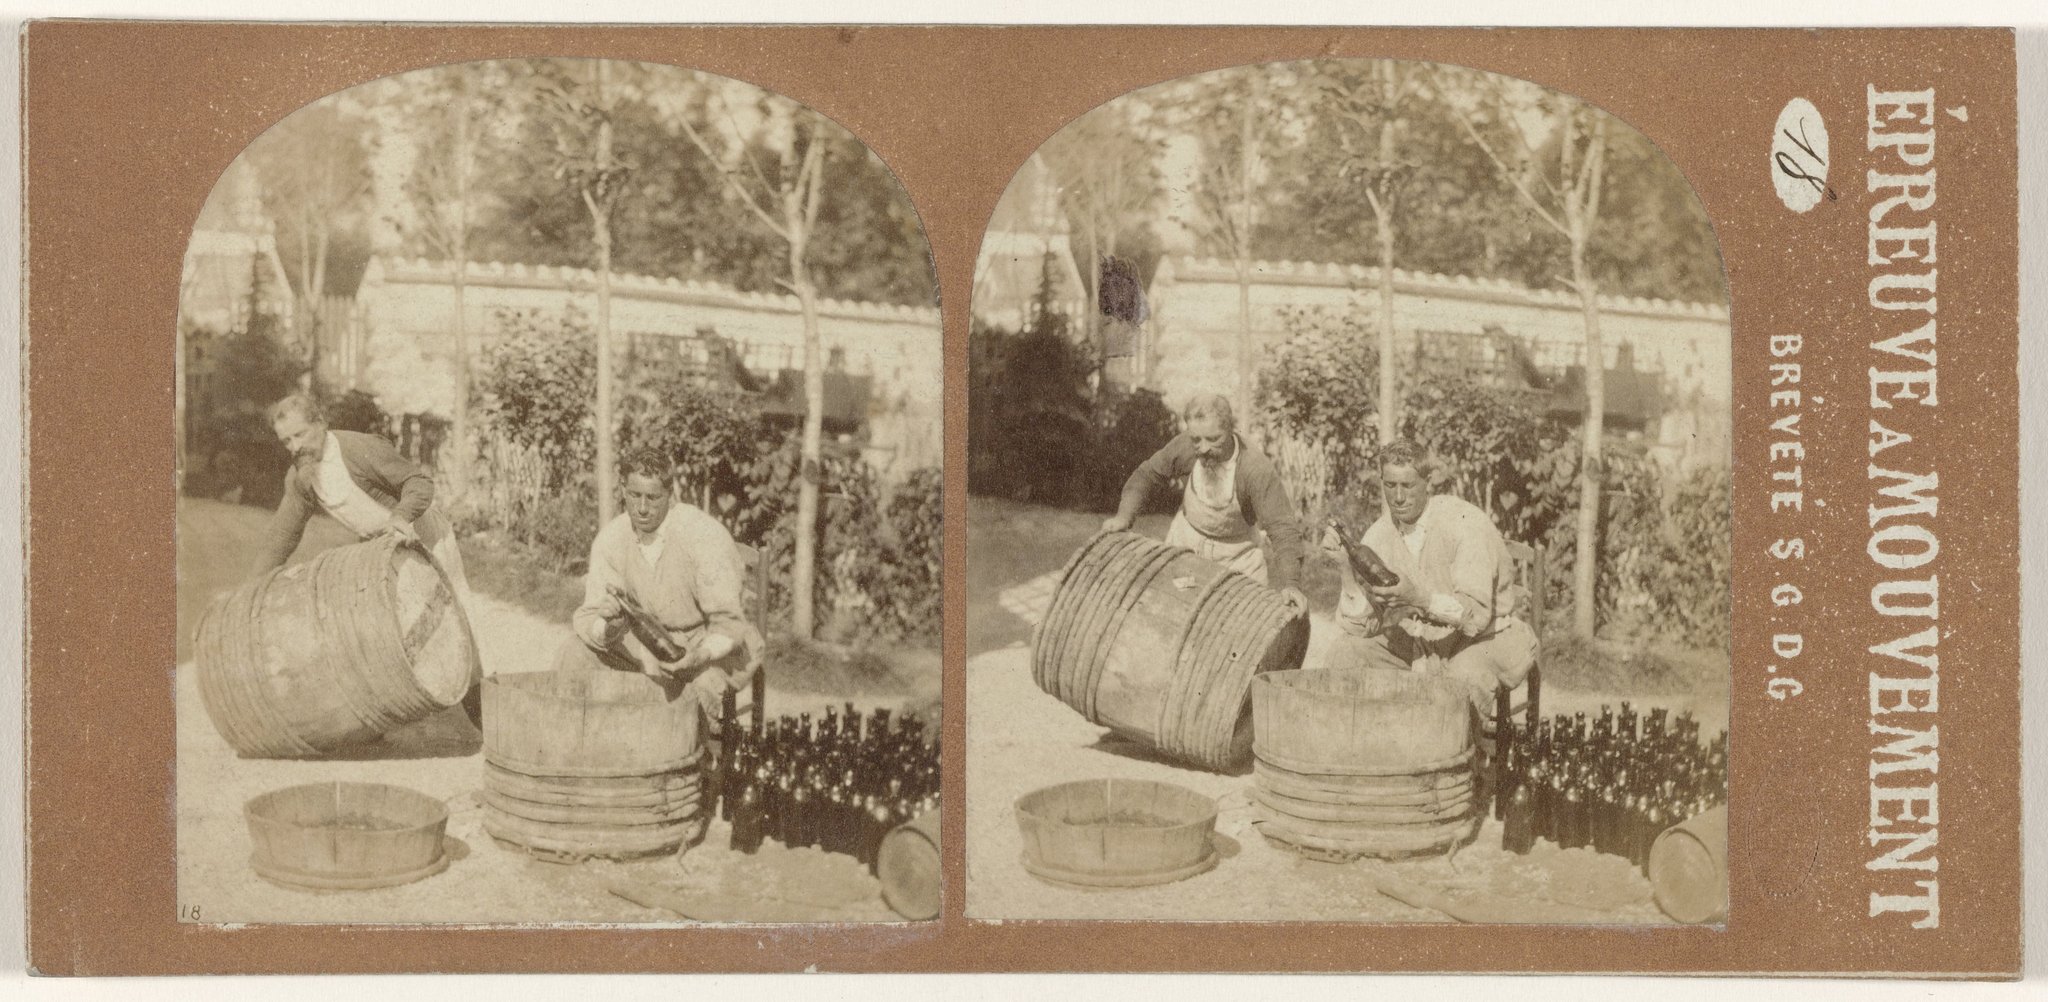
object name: stereograph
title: Twee mannen bottelen wijn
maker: Anonymous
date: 1861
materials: cardboard, paper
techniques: albumen print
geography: france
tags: bottling of wine, france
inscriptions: inscription: ‘g a m’, inscription: ‘BRÉVETÉ S. G. D. G.’, check stamp: ‘BRÉVETÉ [...]’, number: ‘18’